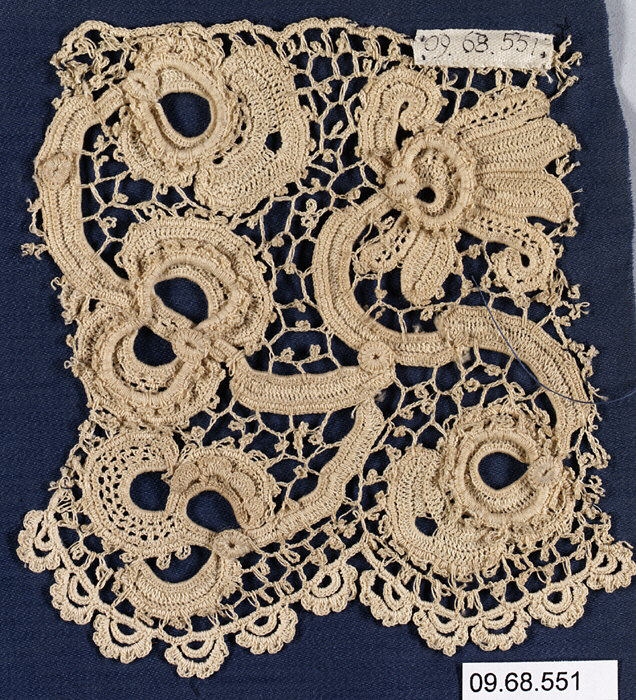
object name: piece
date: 1801-1900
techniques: crochet